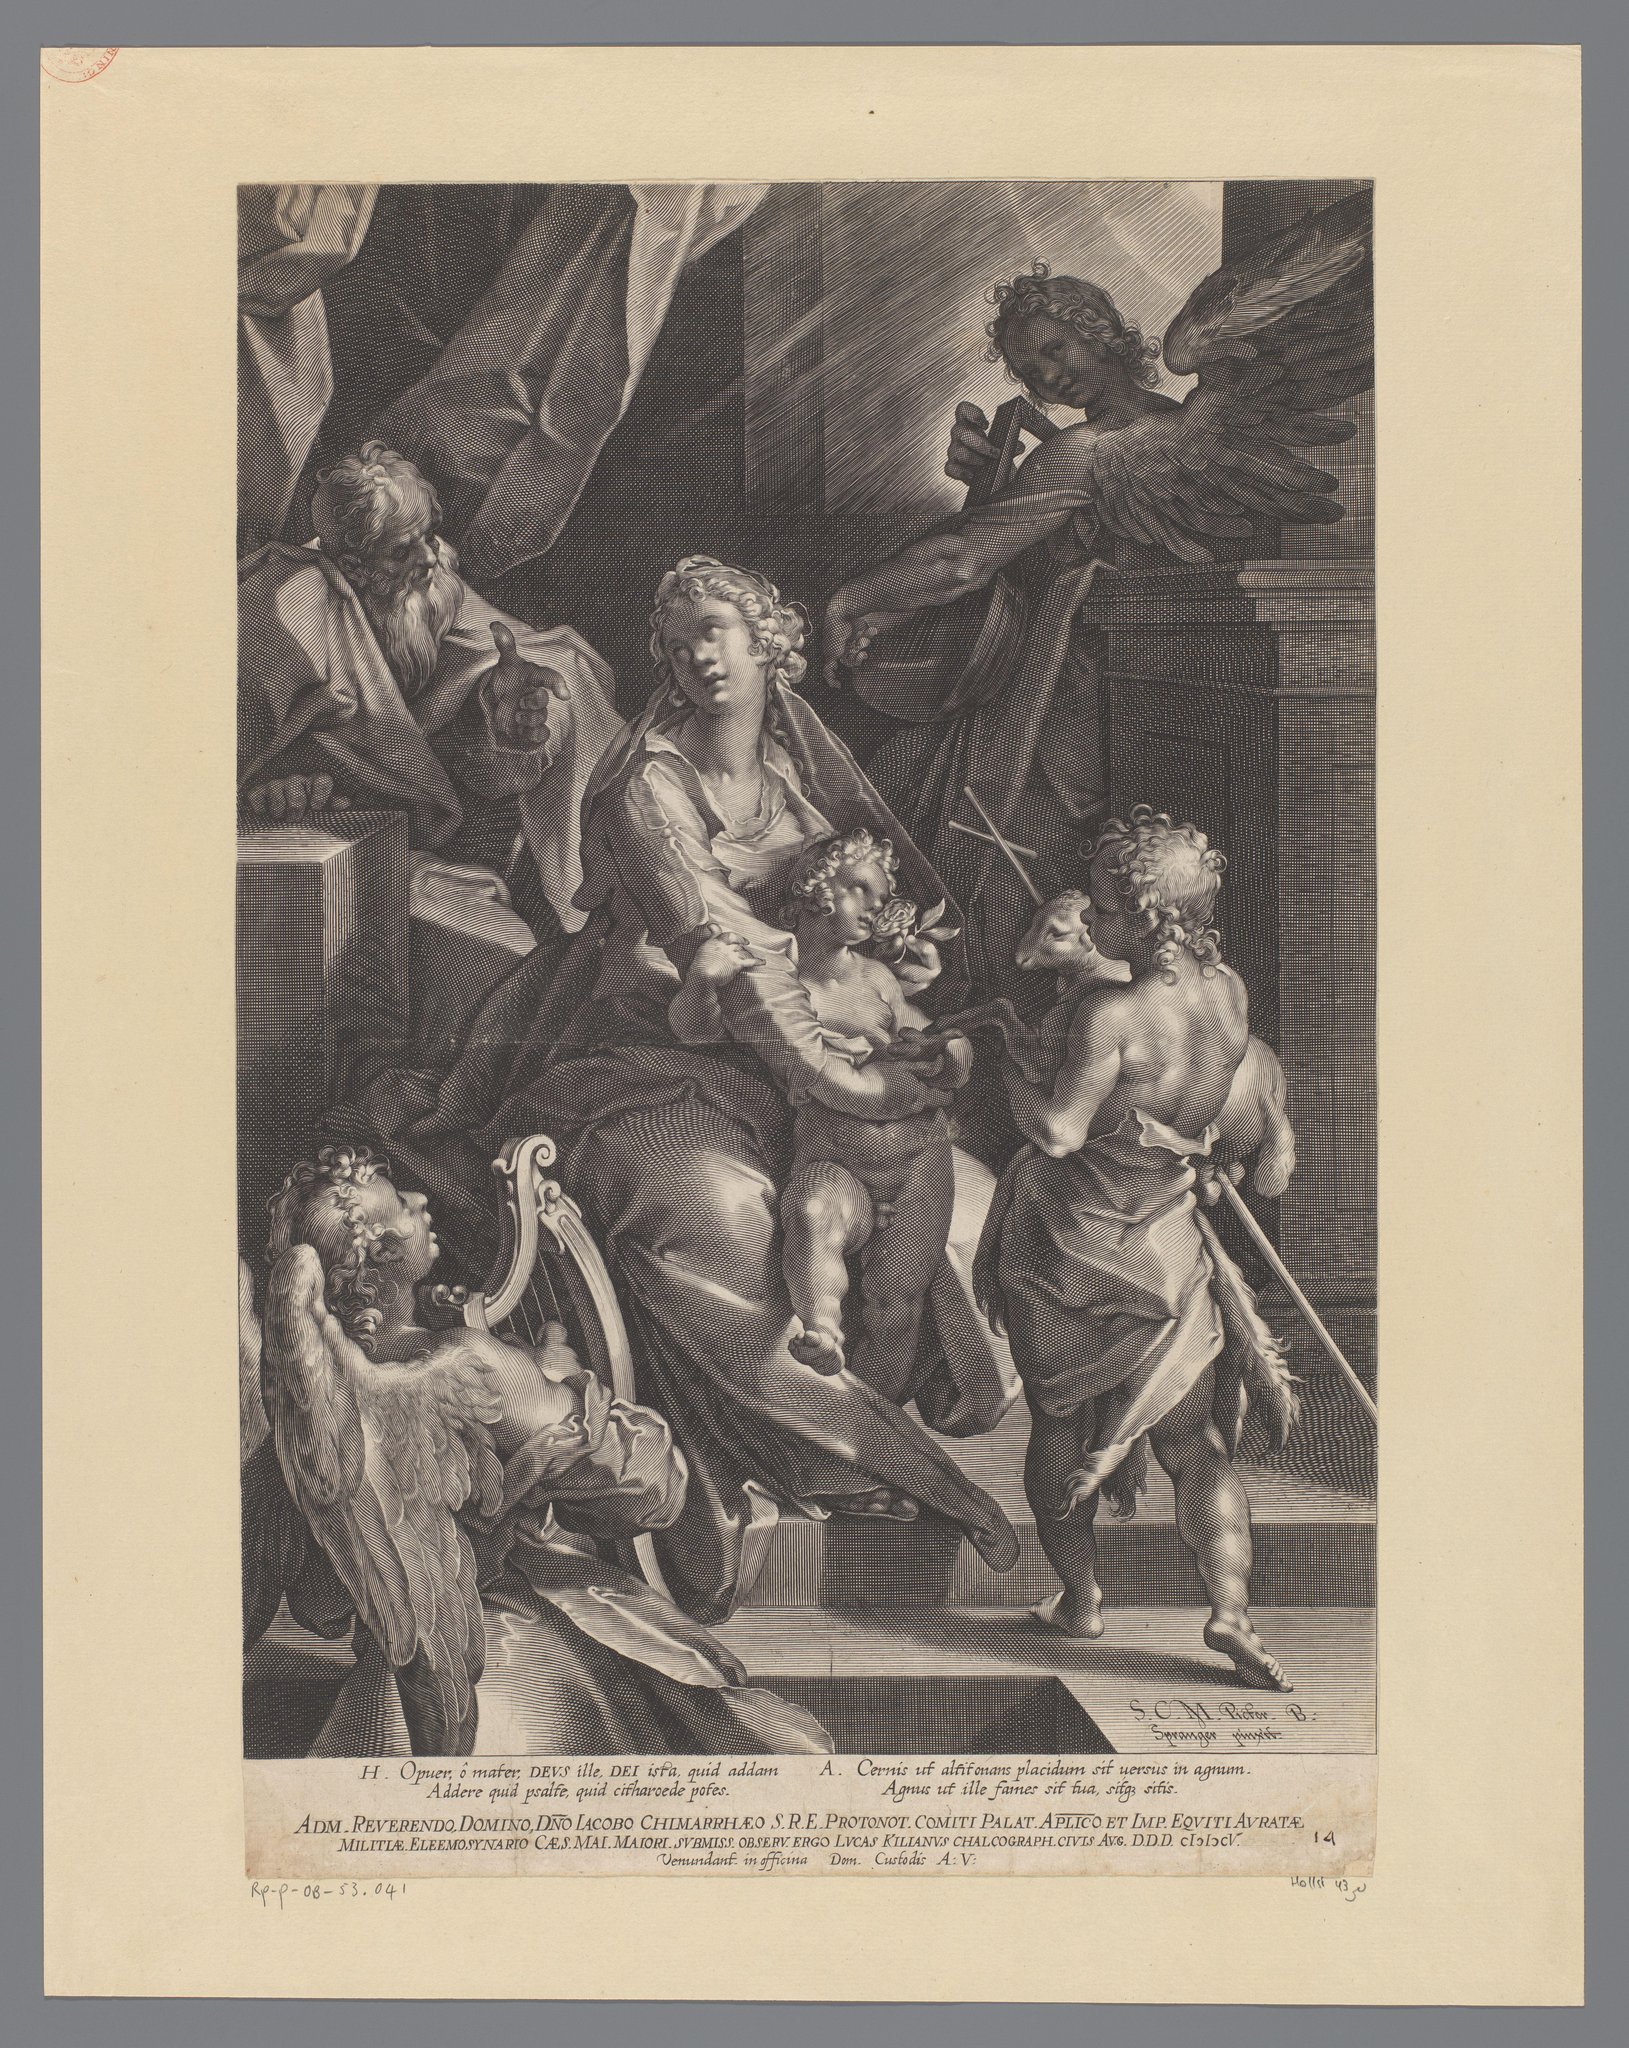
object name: print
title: Heilige Familie met Johannes de Doper en twee engelen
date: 1605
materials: paper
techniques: engraving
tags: holy family with john the baptist (as child) (+ angel(s)), string instruments (plucked)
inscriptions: collector's mark: Lugt 240